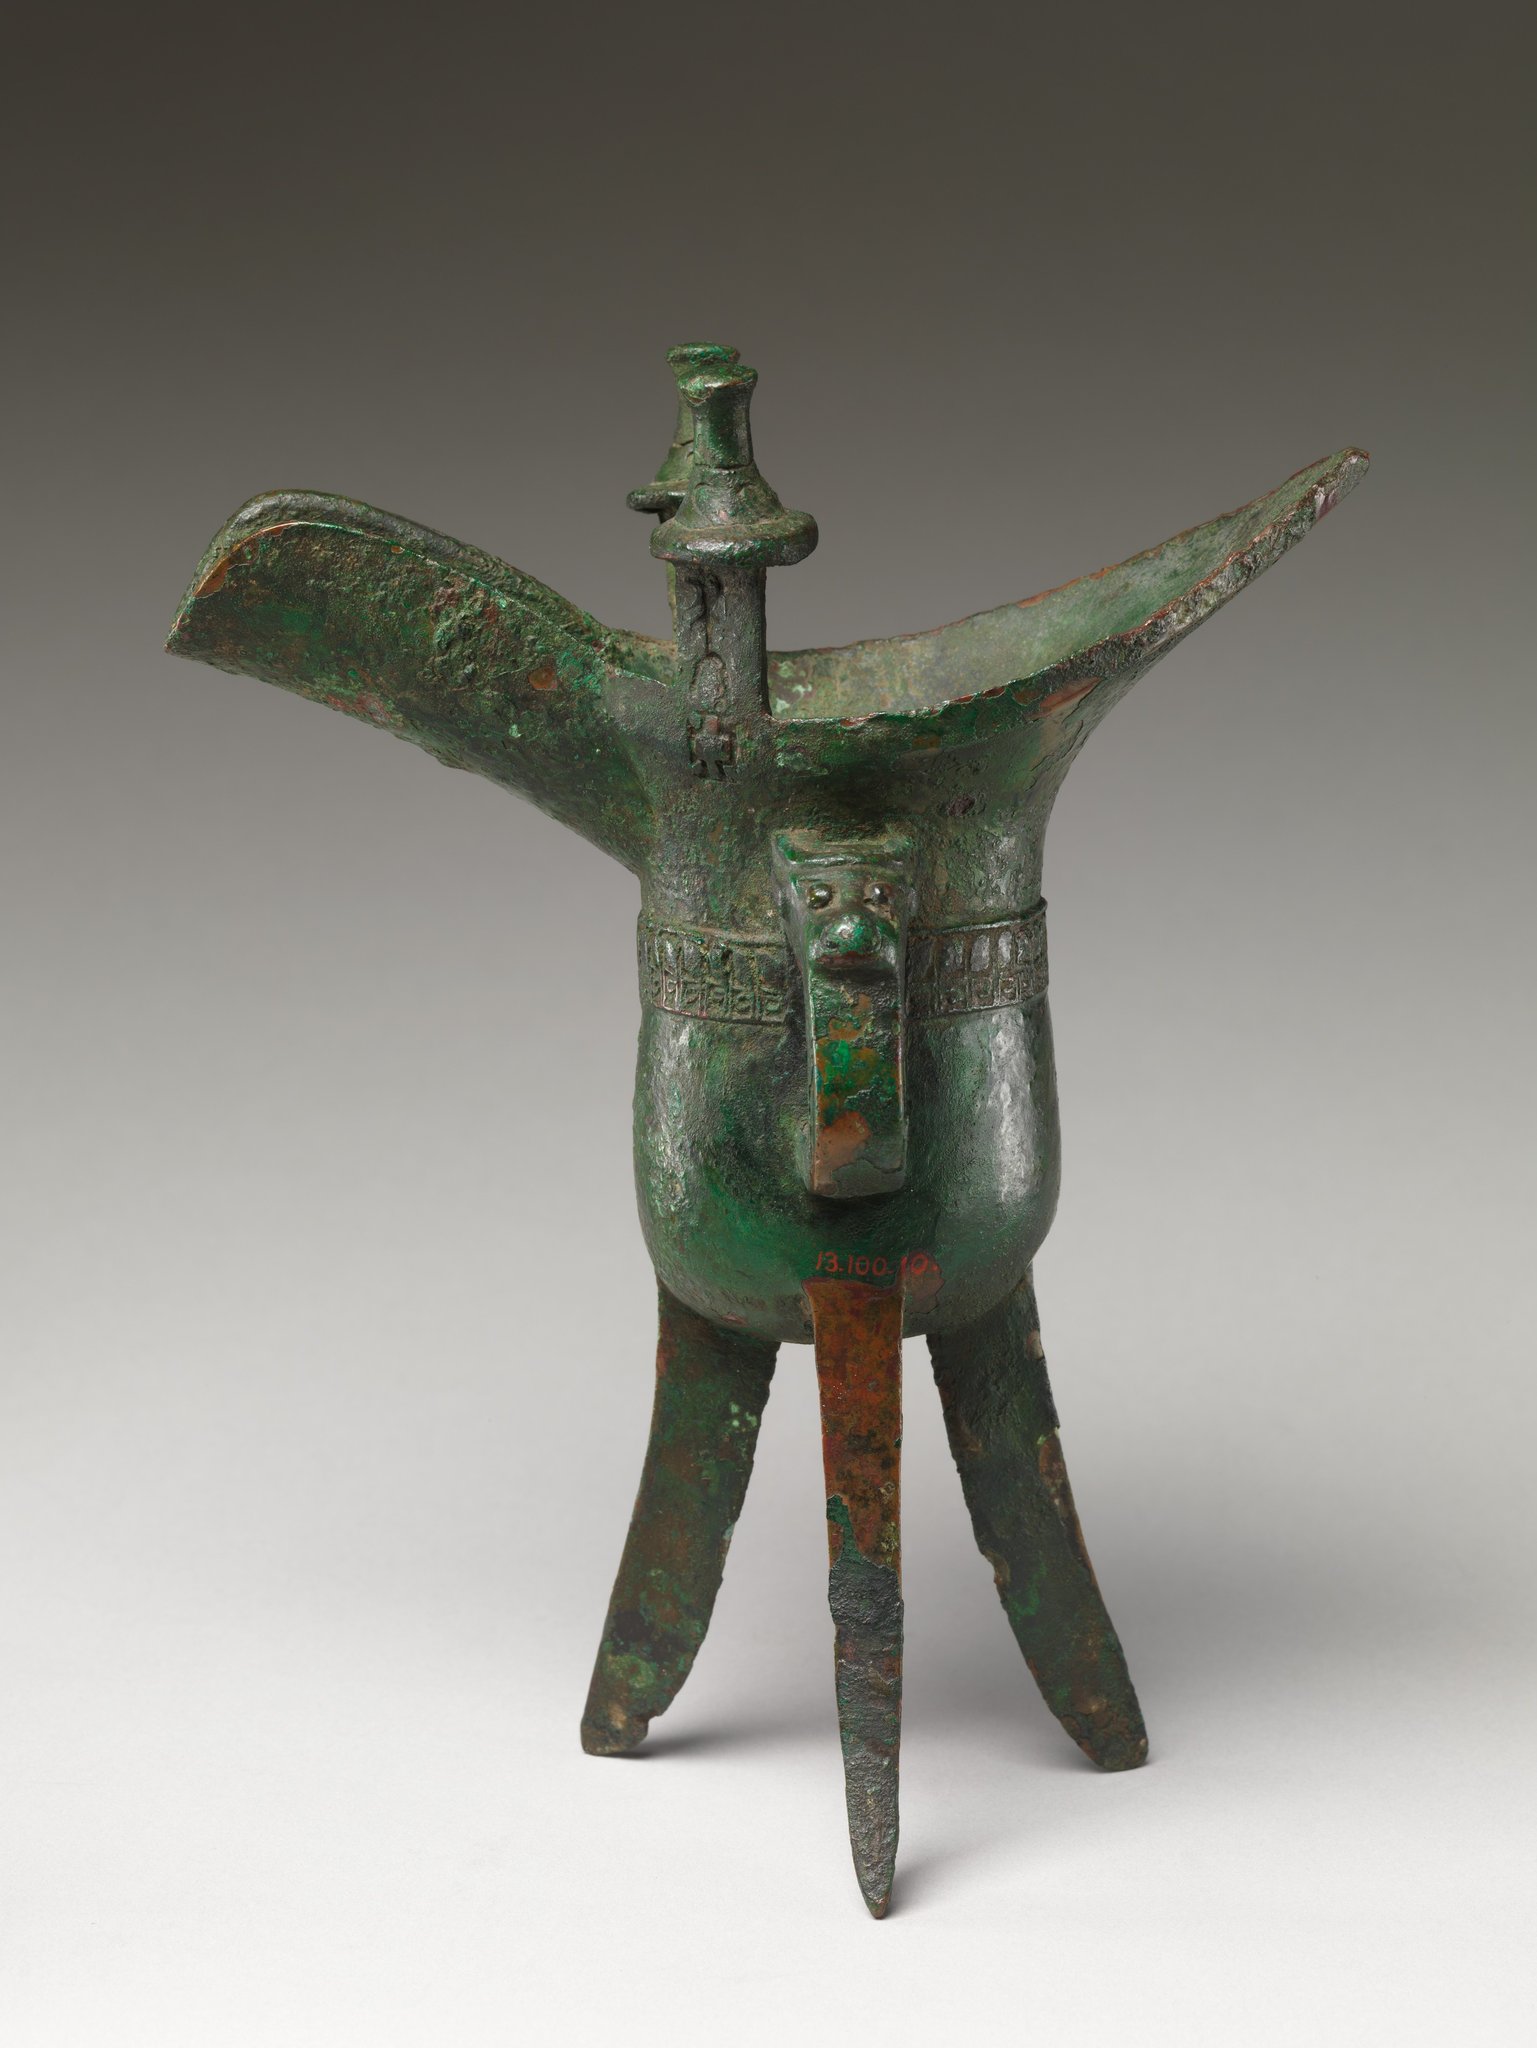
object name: wine warmer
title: Wine warmer (jue) in ancient style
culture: chinese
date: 1801-1900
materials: bronze, patina